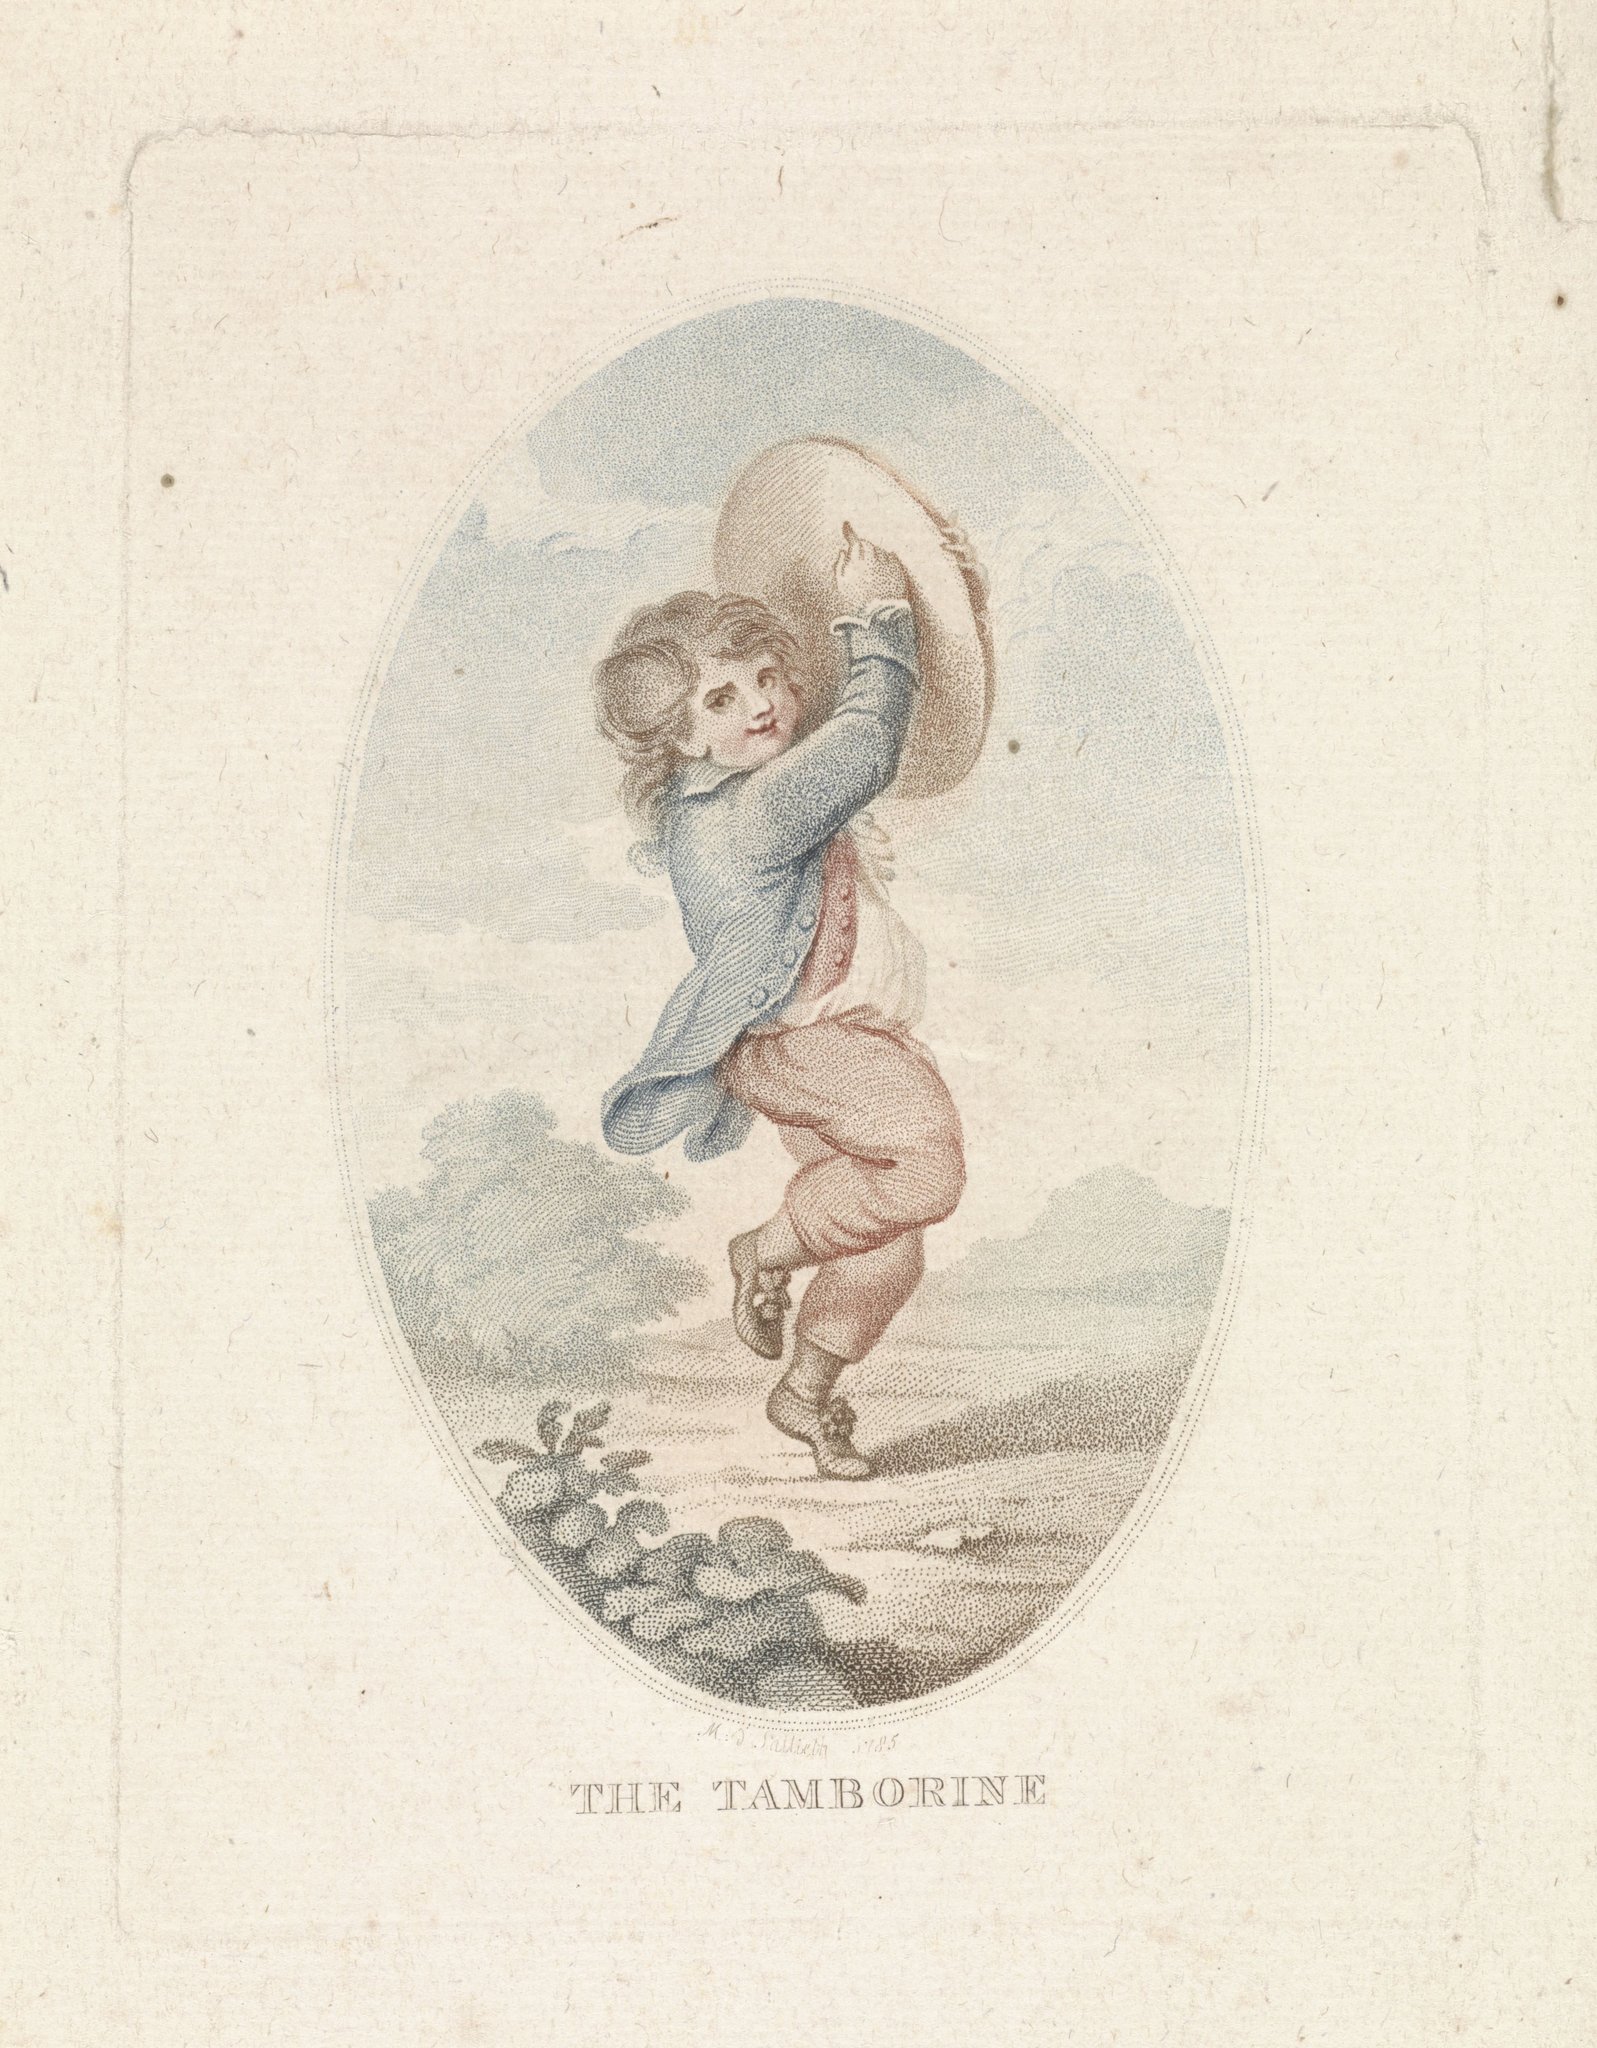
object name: print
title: The Tamborine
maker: mathias de sallieth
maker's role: print maker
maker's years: 1749-1791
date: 1785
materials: paper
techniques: etching, hand coloring, lithography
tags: tambourine, children playing musical instruments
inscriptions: collector's mark: Lugt 2233